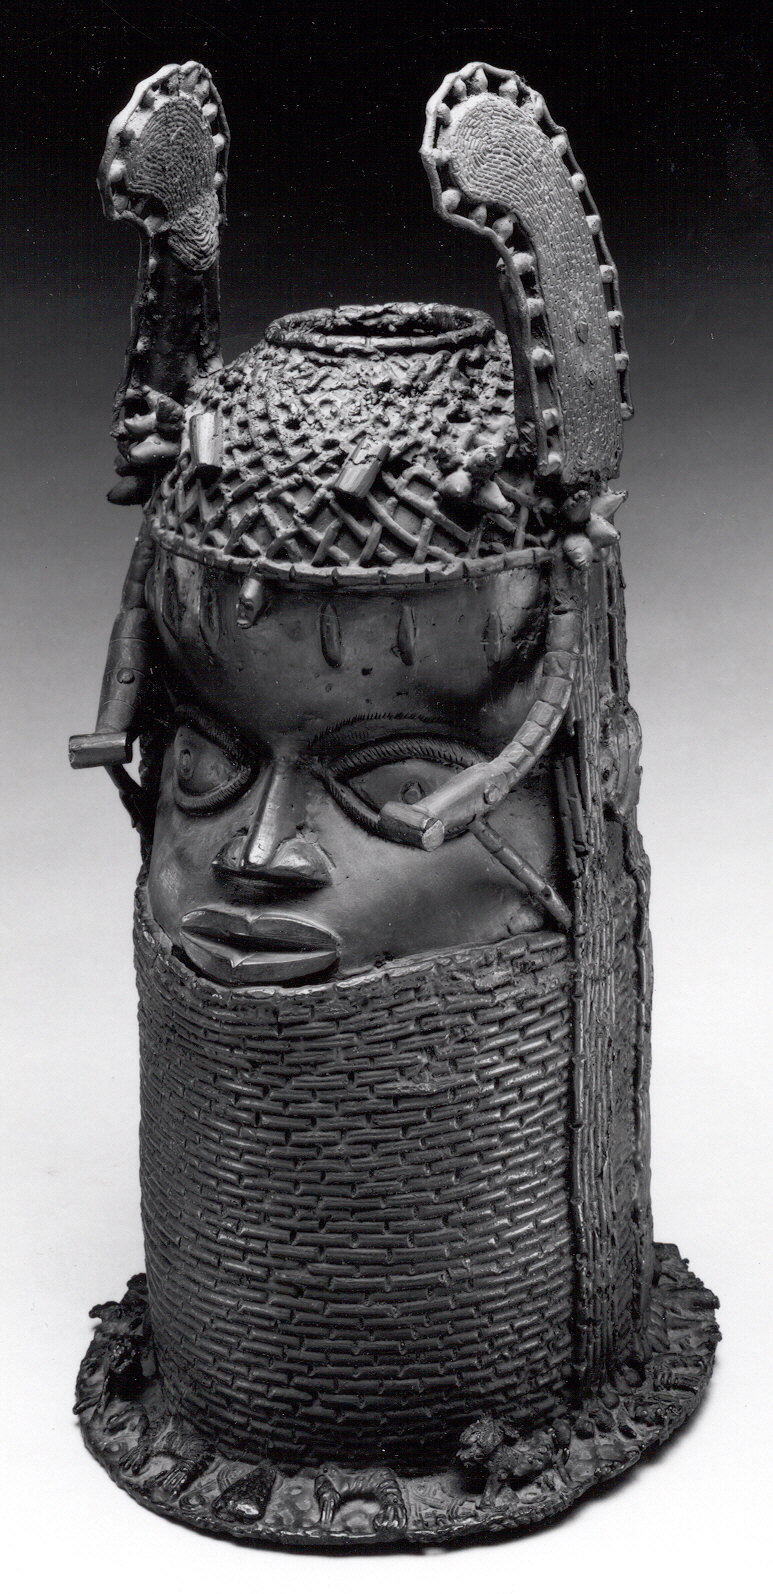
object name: head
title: Head of an Oba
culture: edo period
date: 1801-1900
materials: brass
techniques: casting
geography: nigeria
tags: heads